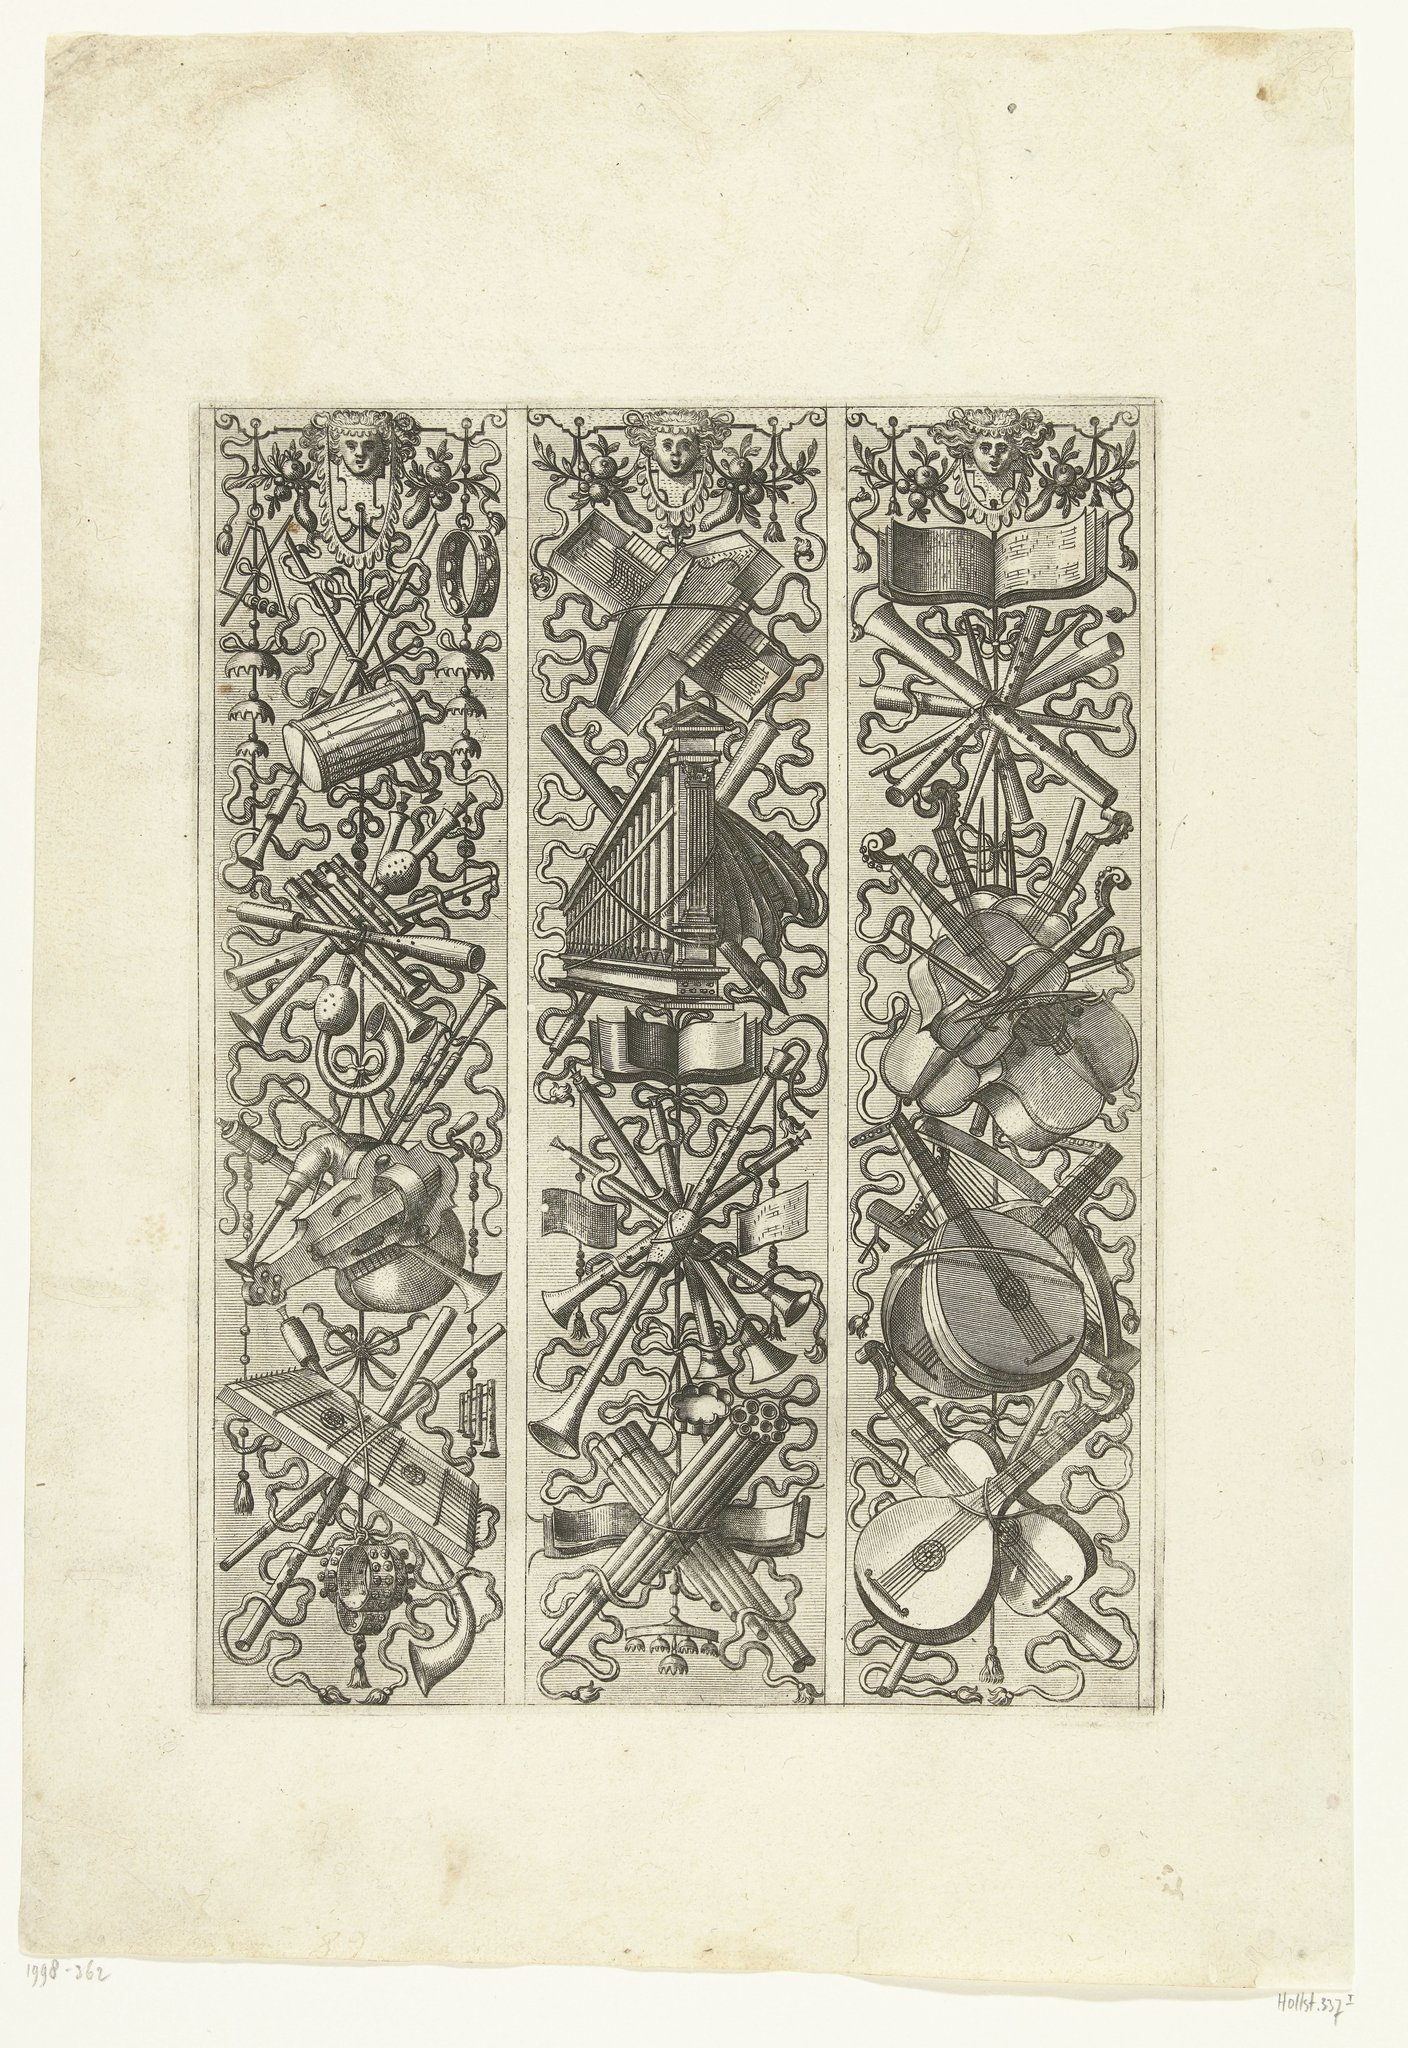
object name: print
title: Panoplia sev armamentarium…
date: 1572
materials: paper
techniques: etching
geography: netherlands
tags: musical instruments; group of musical instruments, trophy, i.e.: decorative arrangement of symbolic or typical objects ~ ornament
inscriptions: : ‘.’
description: Drie verticale trofeeën met muziekinstrumenten: tokkel- en strijkinstrumenten, fluiten, doedelzak, orgel, citer en clavichord. Uit serie, bestaande uit een titelblad en 16 bladen.